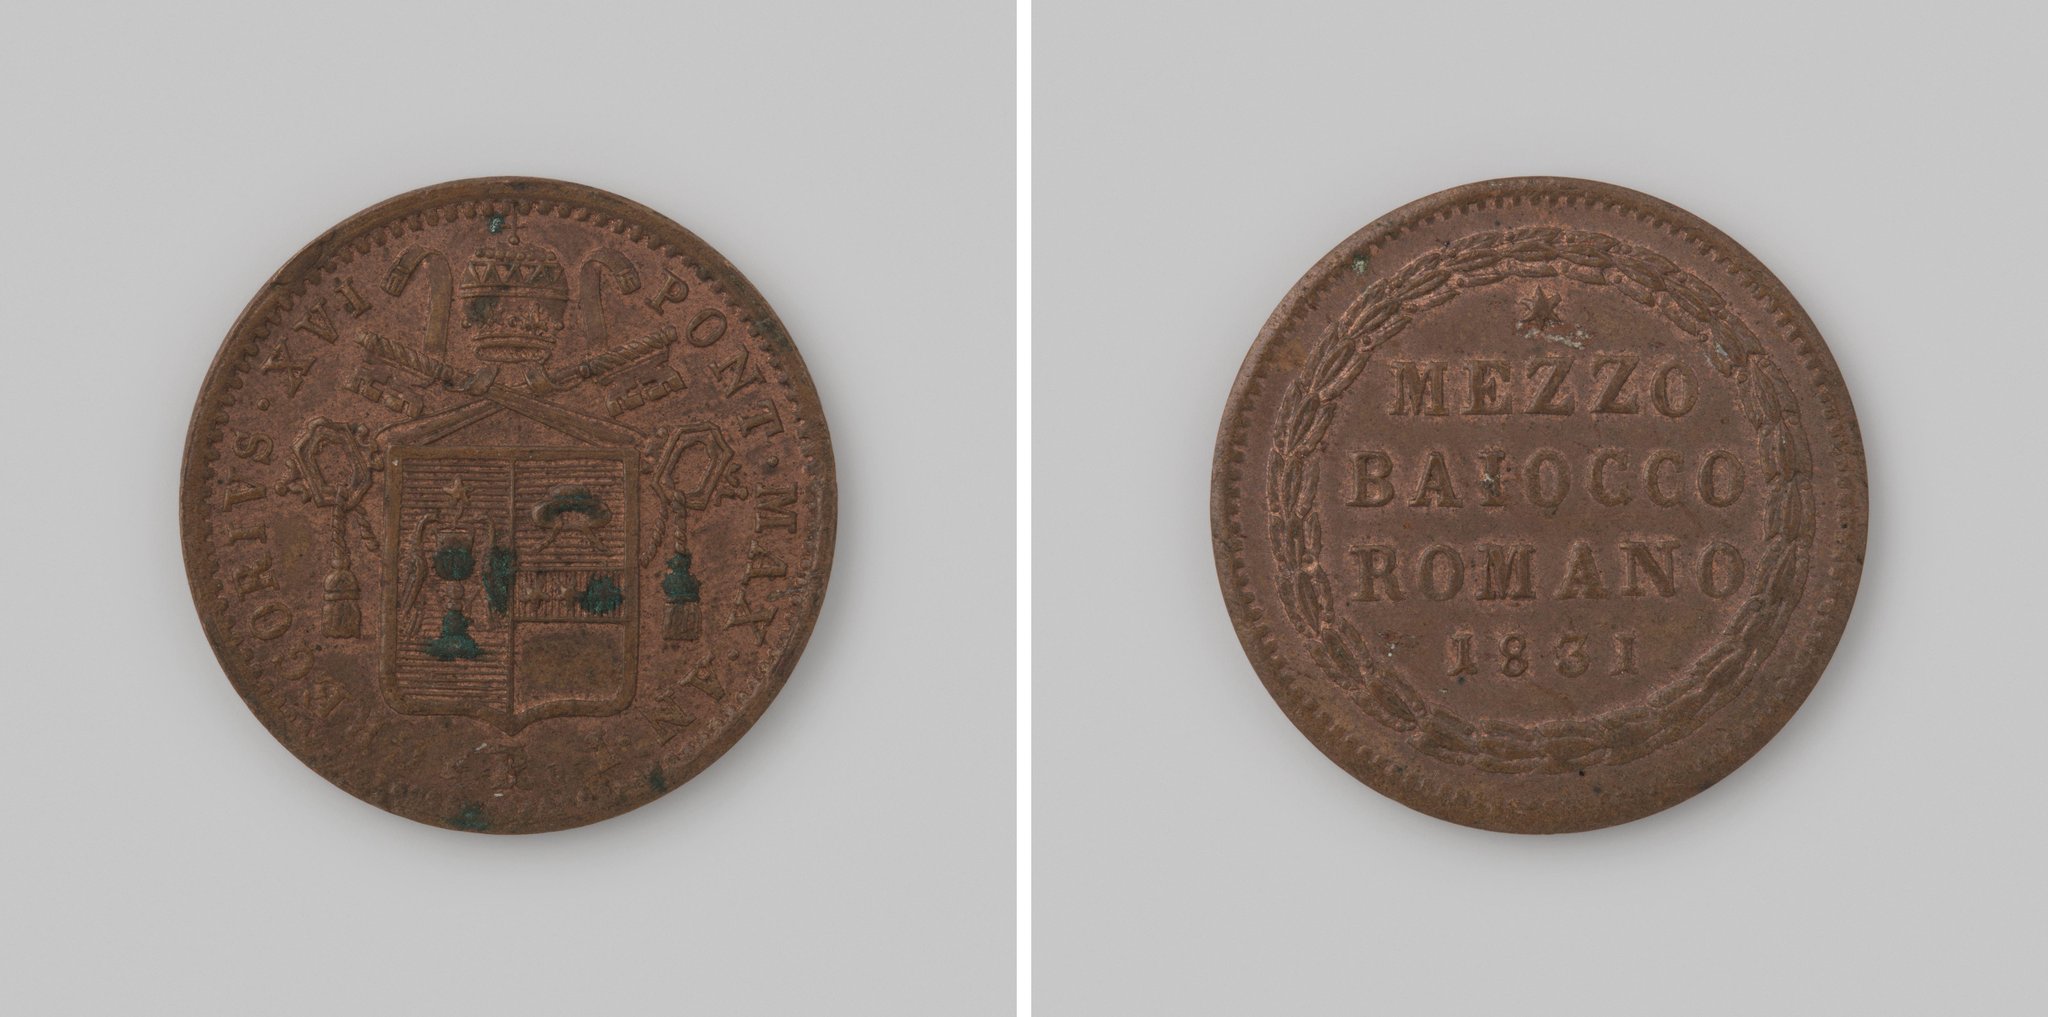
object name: coin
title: ½ baiocco romano uit de kerkelijke Staat van paus Gregorius XVI, 1831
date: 1831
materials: copper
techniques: striking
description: Koperen munt. Voorzijde: versierd wapenschild, waarboven twee gekruiste sleutels. Daarboven tiara. Keerzijde: binnen krans van bladeren waarde-aanduiding in drie regels, waaronder jaartal. Gladde rand.